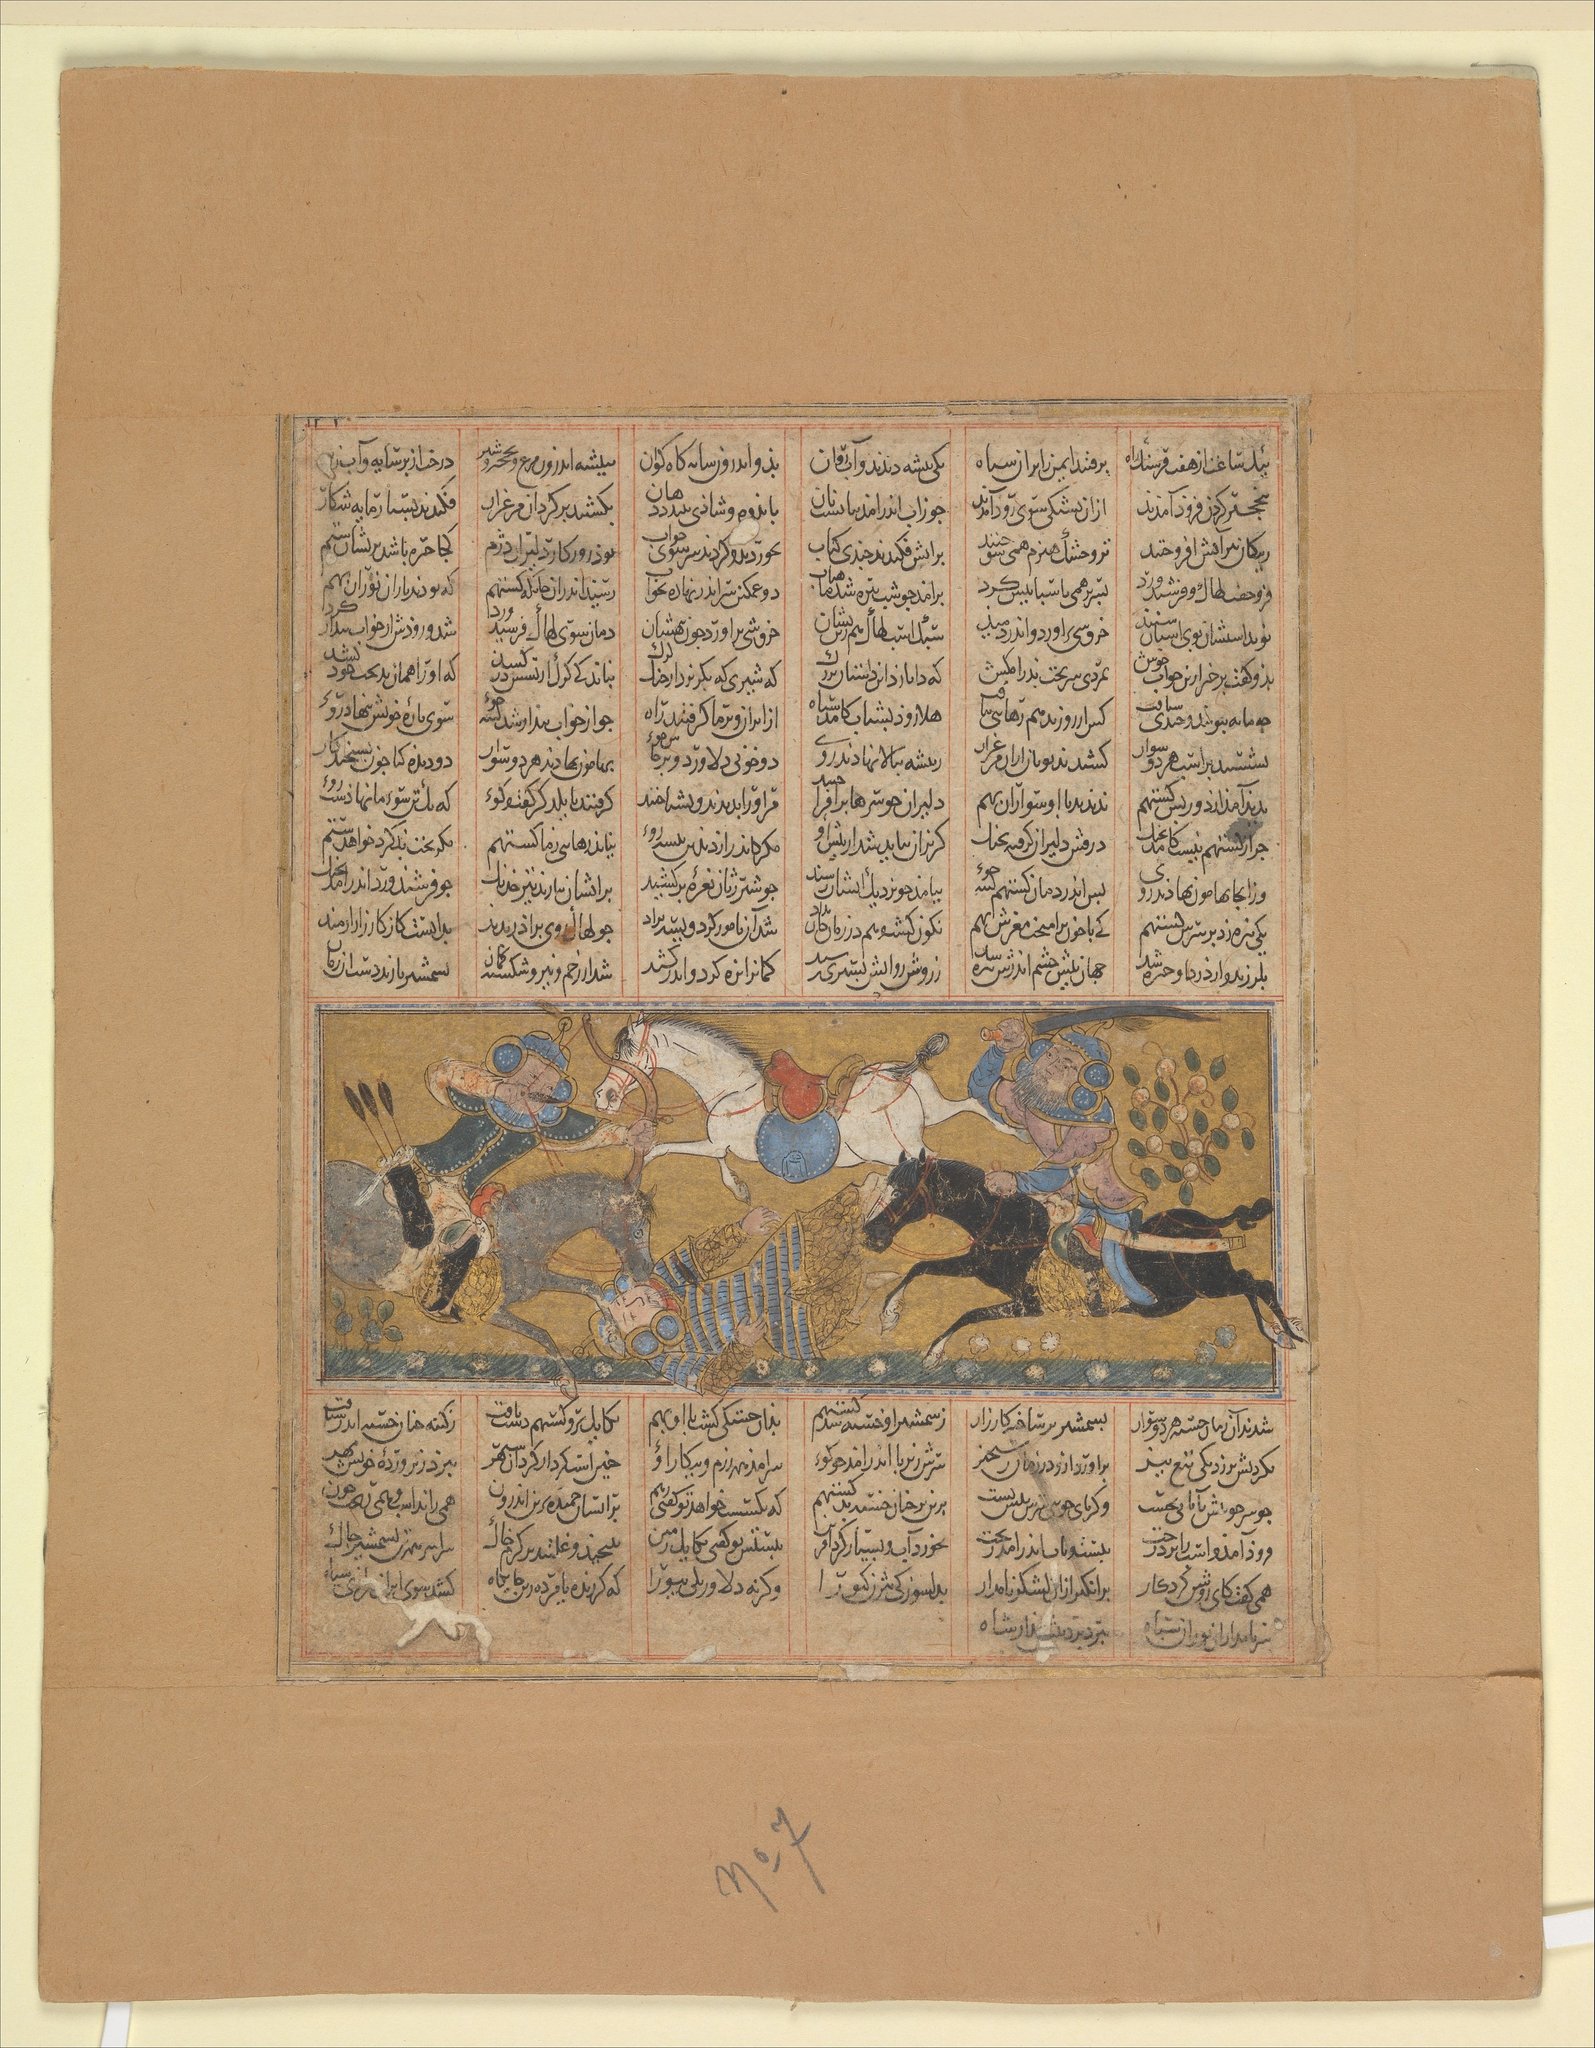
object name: folio from an illustrated manuscript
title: "Gustaham Kills Lahhak and Farshidvard", Folio from a Shahnama (Book of Kings)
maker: abu'l qasim firdausi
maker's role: author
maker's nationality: iranian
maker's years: 935-1020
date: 1300-1330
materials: gold, ink, paper, silver, watercolor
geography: iran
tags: bow and arrow,men,horses